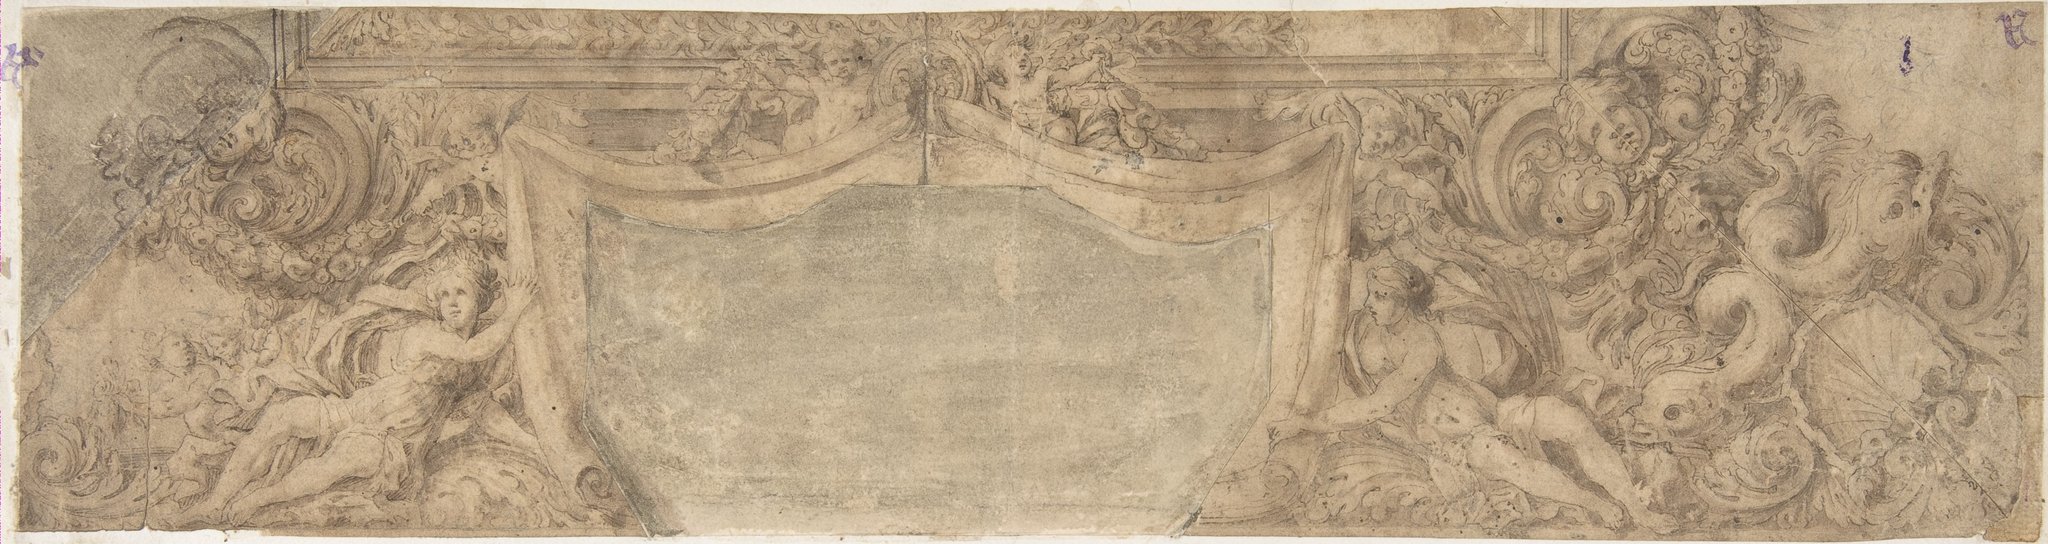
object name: drawing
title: Design for Part of a Ceiling or Cornice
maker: anonymous, french, 17th century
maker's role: artist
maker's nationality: french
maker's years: 1600-1700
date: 1601-1700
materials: ink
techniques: brush, pen, wash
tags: ceilings